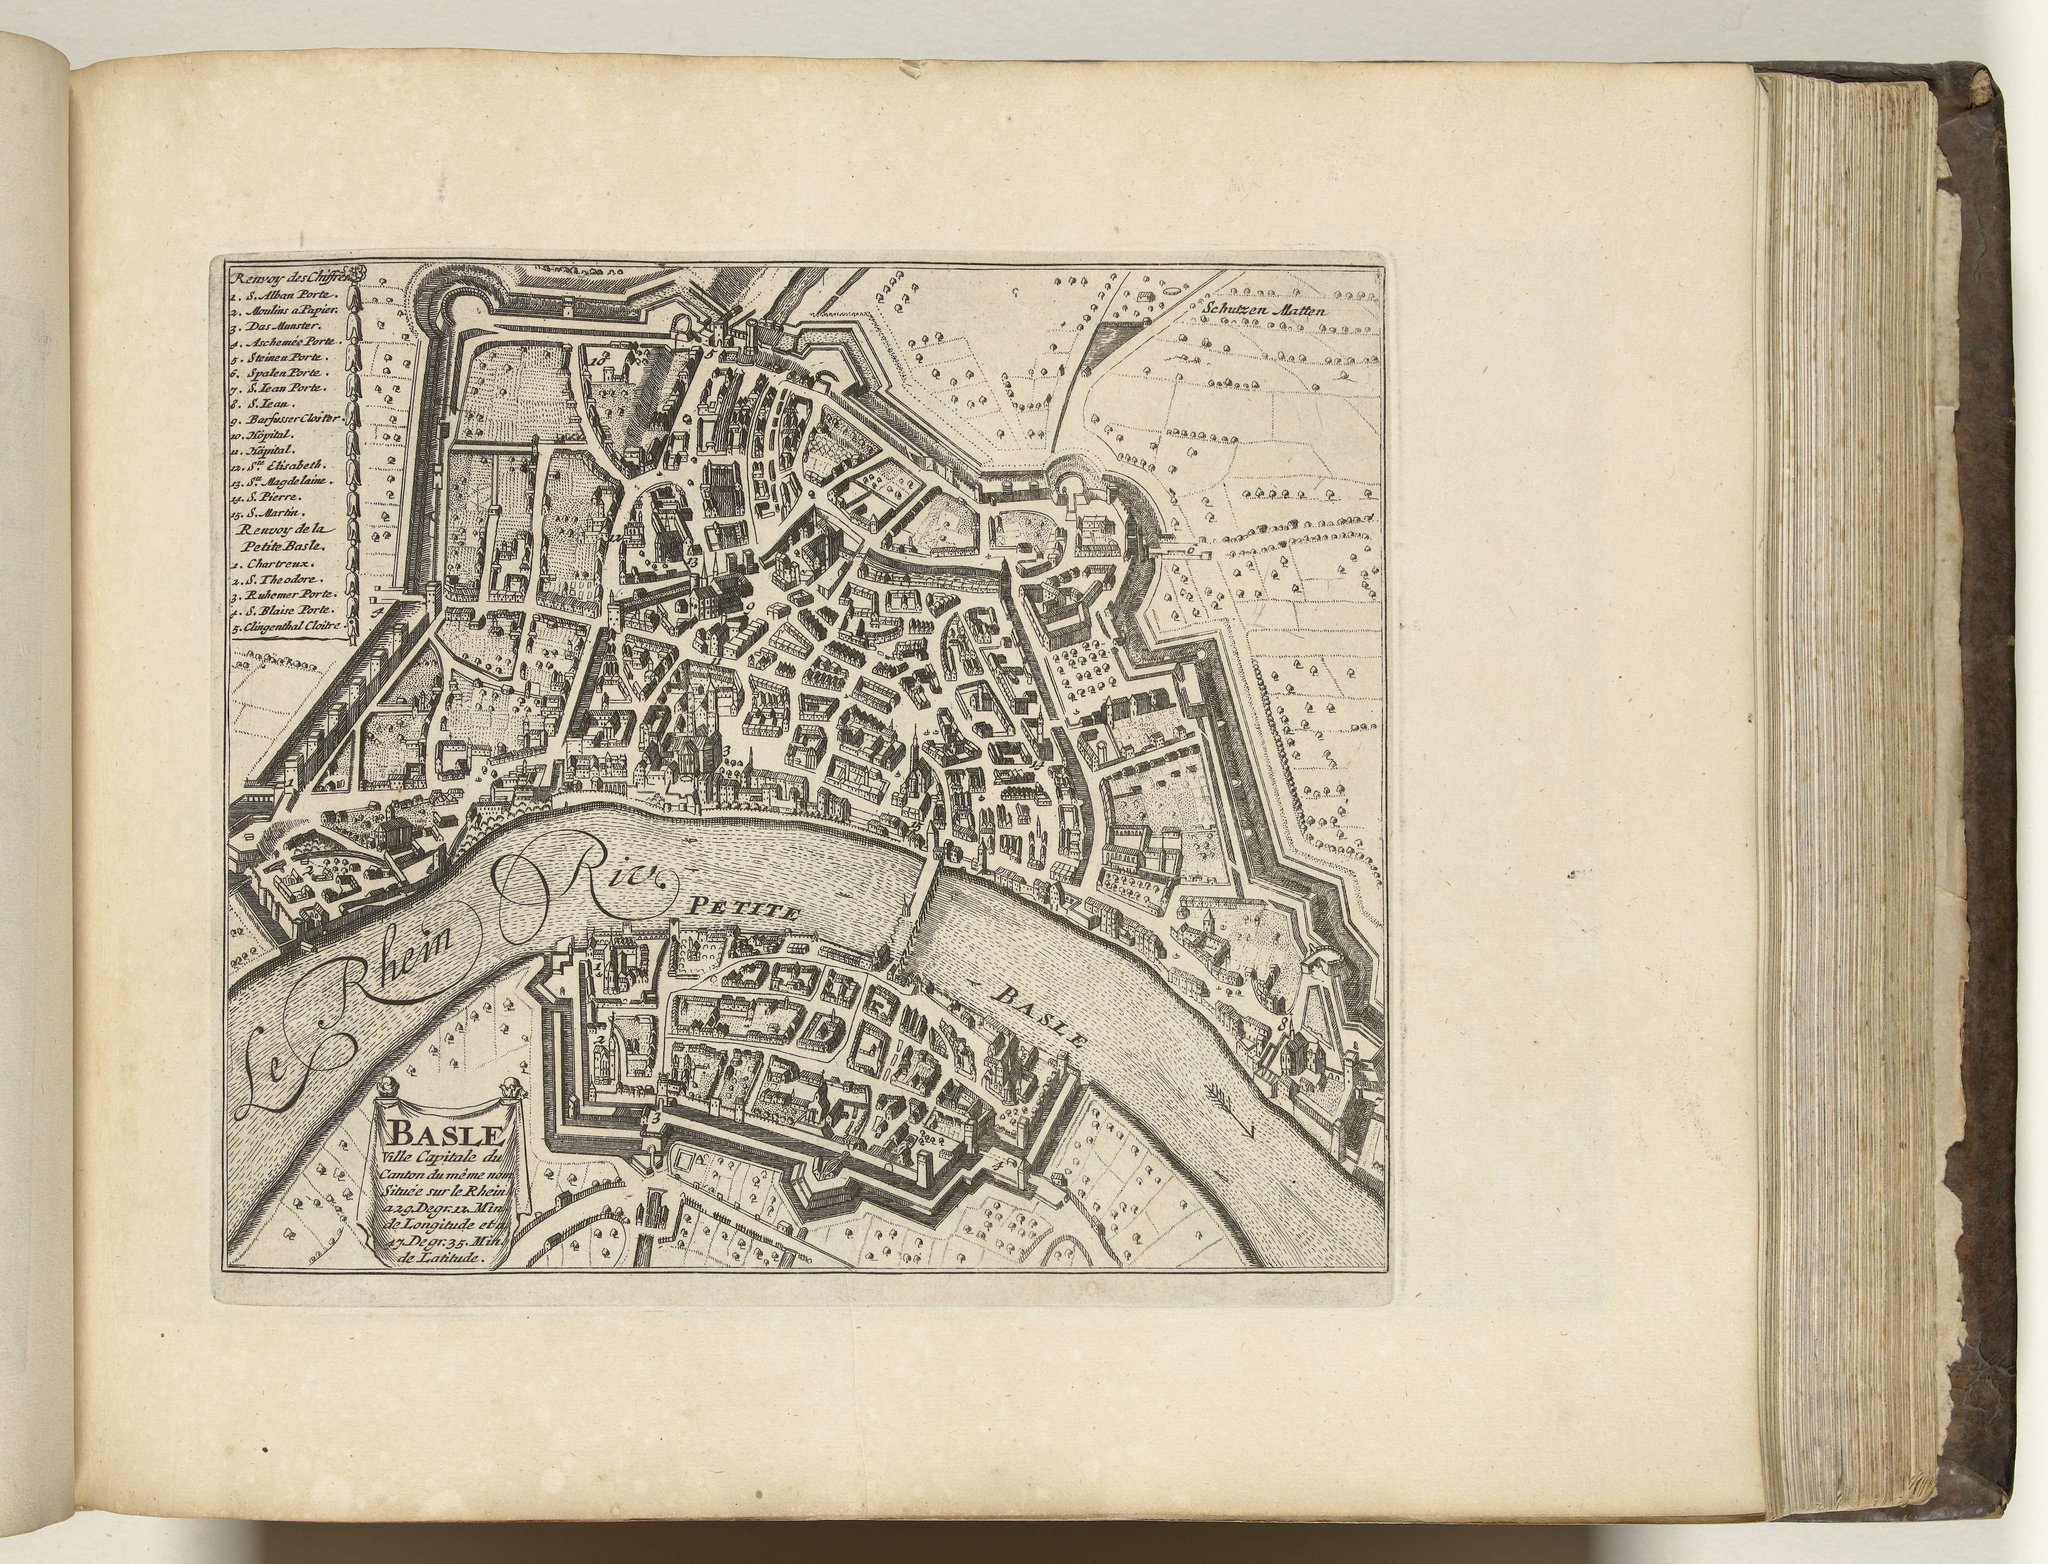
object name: print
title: Basle Ville Capitale du Canton du même nom (...)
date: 1693-1696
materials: paper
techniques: etching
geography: paris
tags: maps of cities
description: Plattegrond van de Zwitserse stad Basel. Onderdeel van het vijfde deel (1696) van het prentwerk waarin gebundeld zijn de acht delen van Les forces de l'Europe uitgegeven tussen 1693-1697. Het prentwerk bestaat uit 175 platen met plannen (afkomstig van Sébastien Le Prestre, Seigneur de Vauban) van vermaarde sterke steden en vestingen in de Negenjarige Oorlog. Titel en opschriften in het Frans.